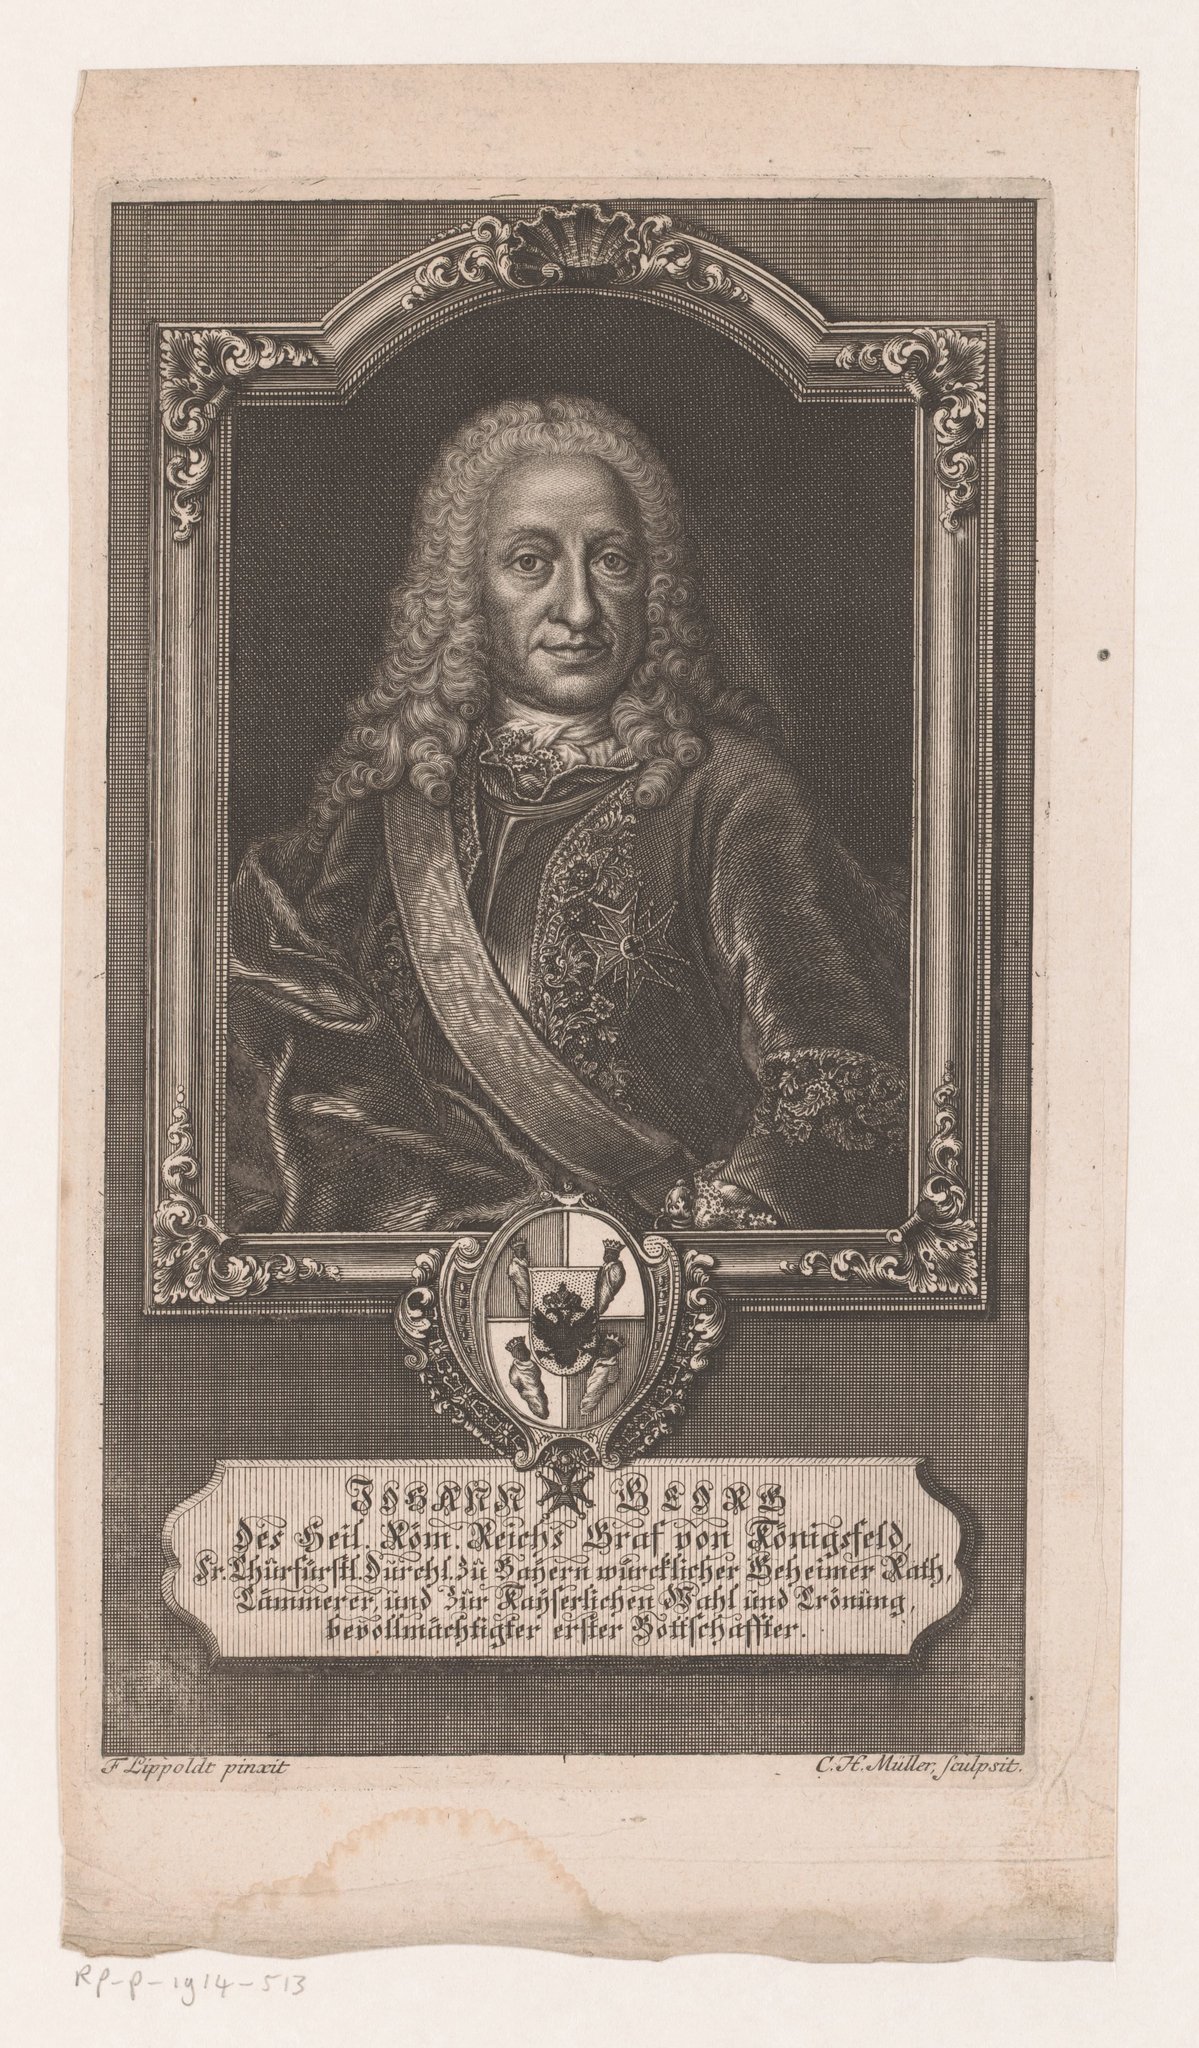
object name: print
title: Portret van Johann Georg, Graf von Königsfeld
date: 1699-1799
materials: paper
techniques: engraving, etching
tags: armour, historical persons, armorial bearing, heraldry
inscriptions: collector's mark: Lugt 2228